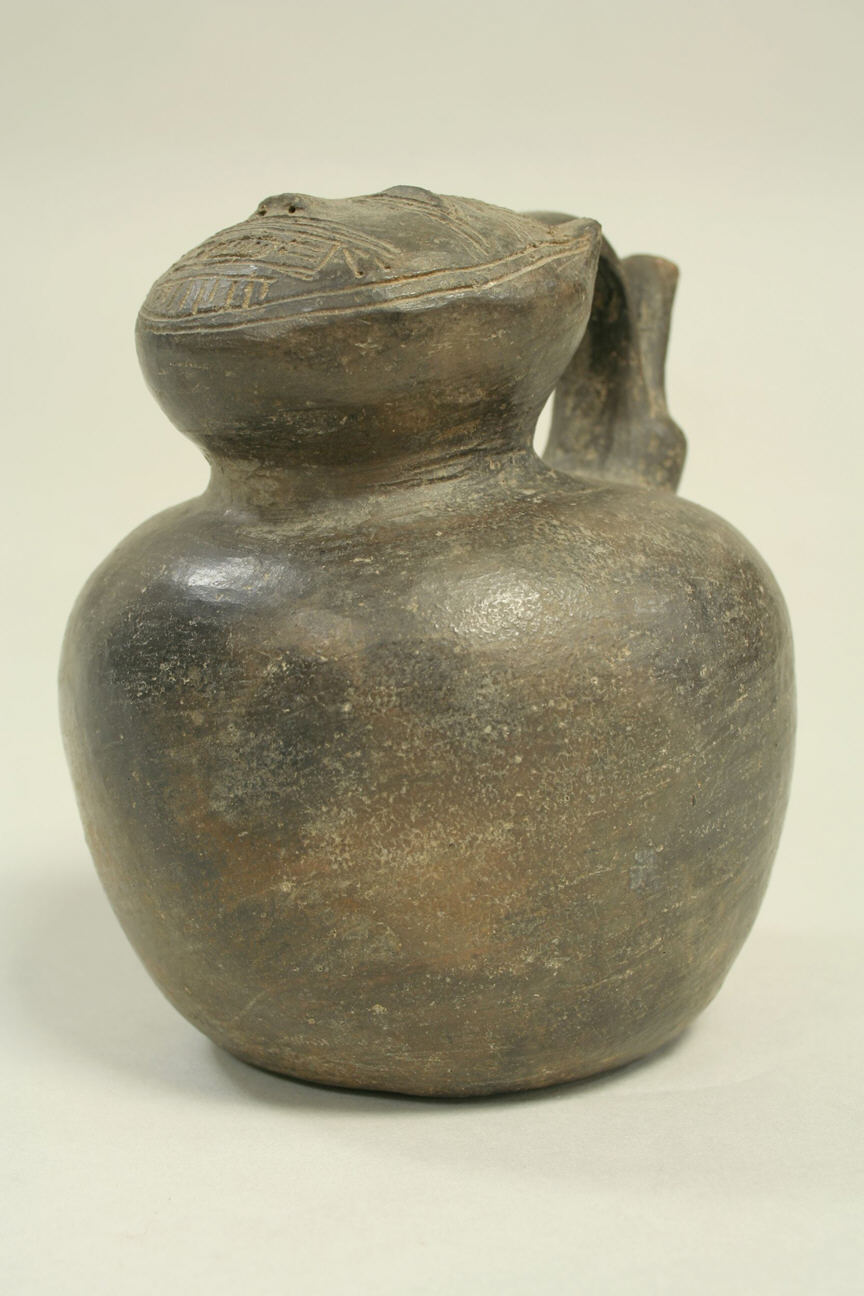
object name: bottle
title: Feline Effigy Bottle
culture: paracas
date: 700-301 BCE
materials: ceramic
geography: peru